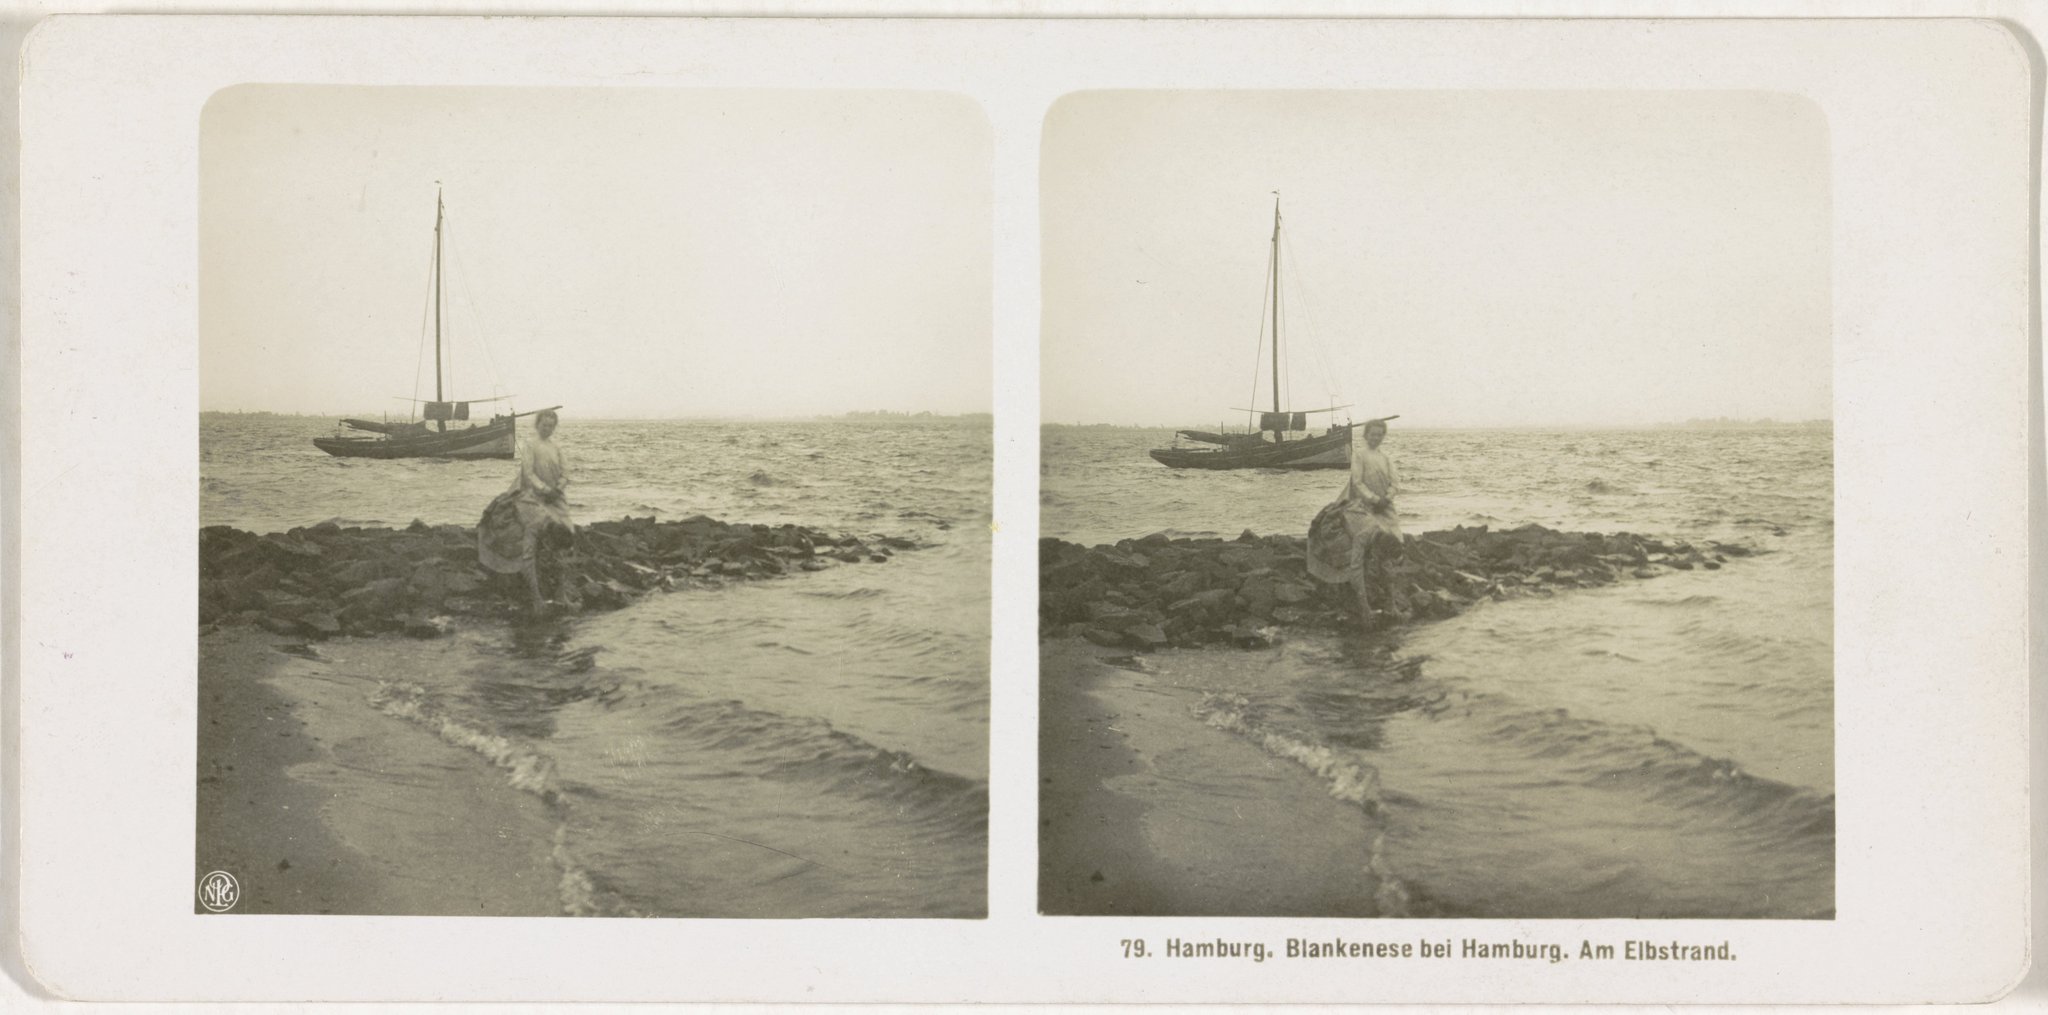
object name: stereograph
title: 79. Hamburg. Blankenese bei Hamburg. Am Elbstrand.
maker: ngp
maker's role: fotograaf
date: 1900-1940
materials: cardboard, paper, photographic support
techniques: gelatin silver print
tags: noord-holland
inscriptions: stamp: ‘Merkelbach & Co, Amsterdam.’